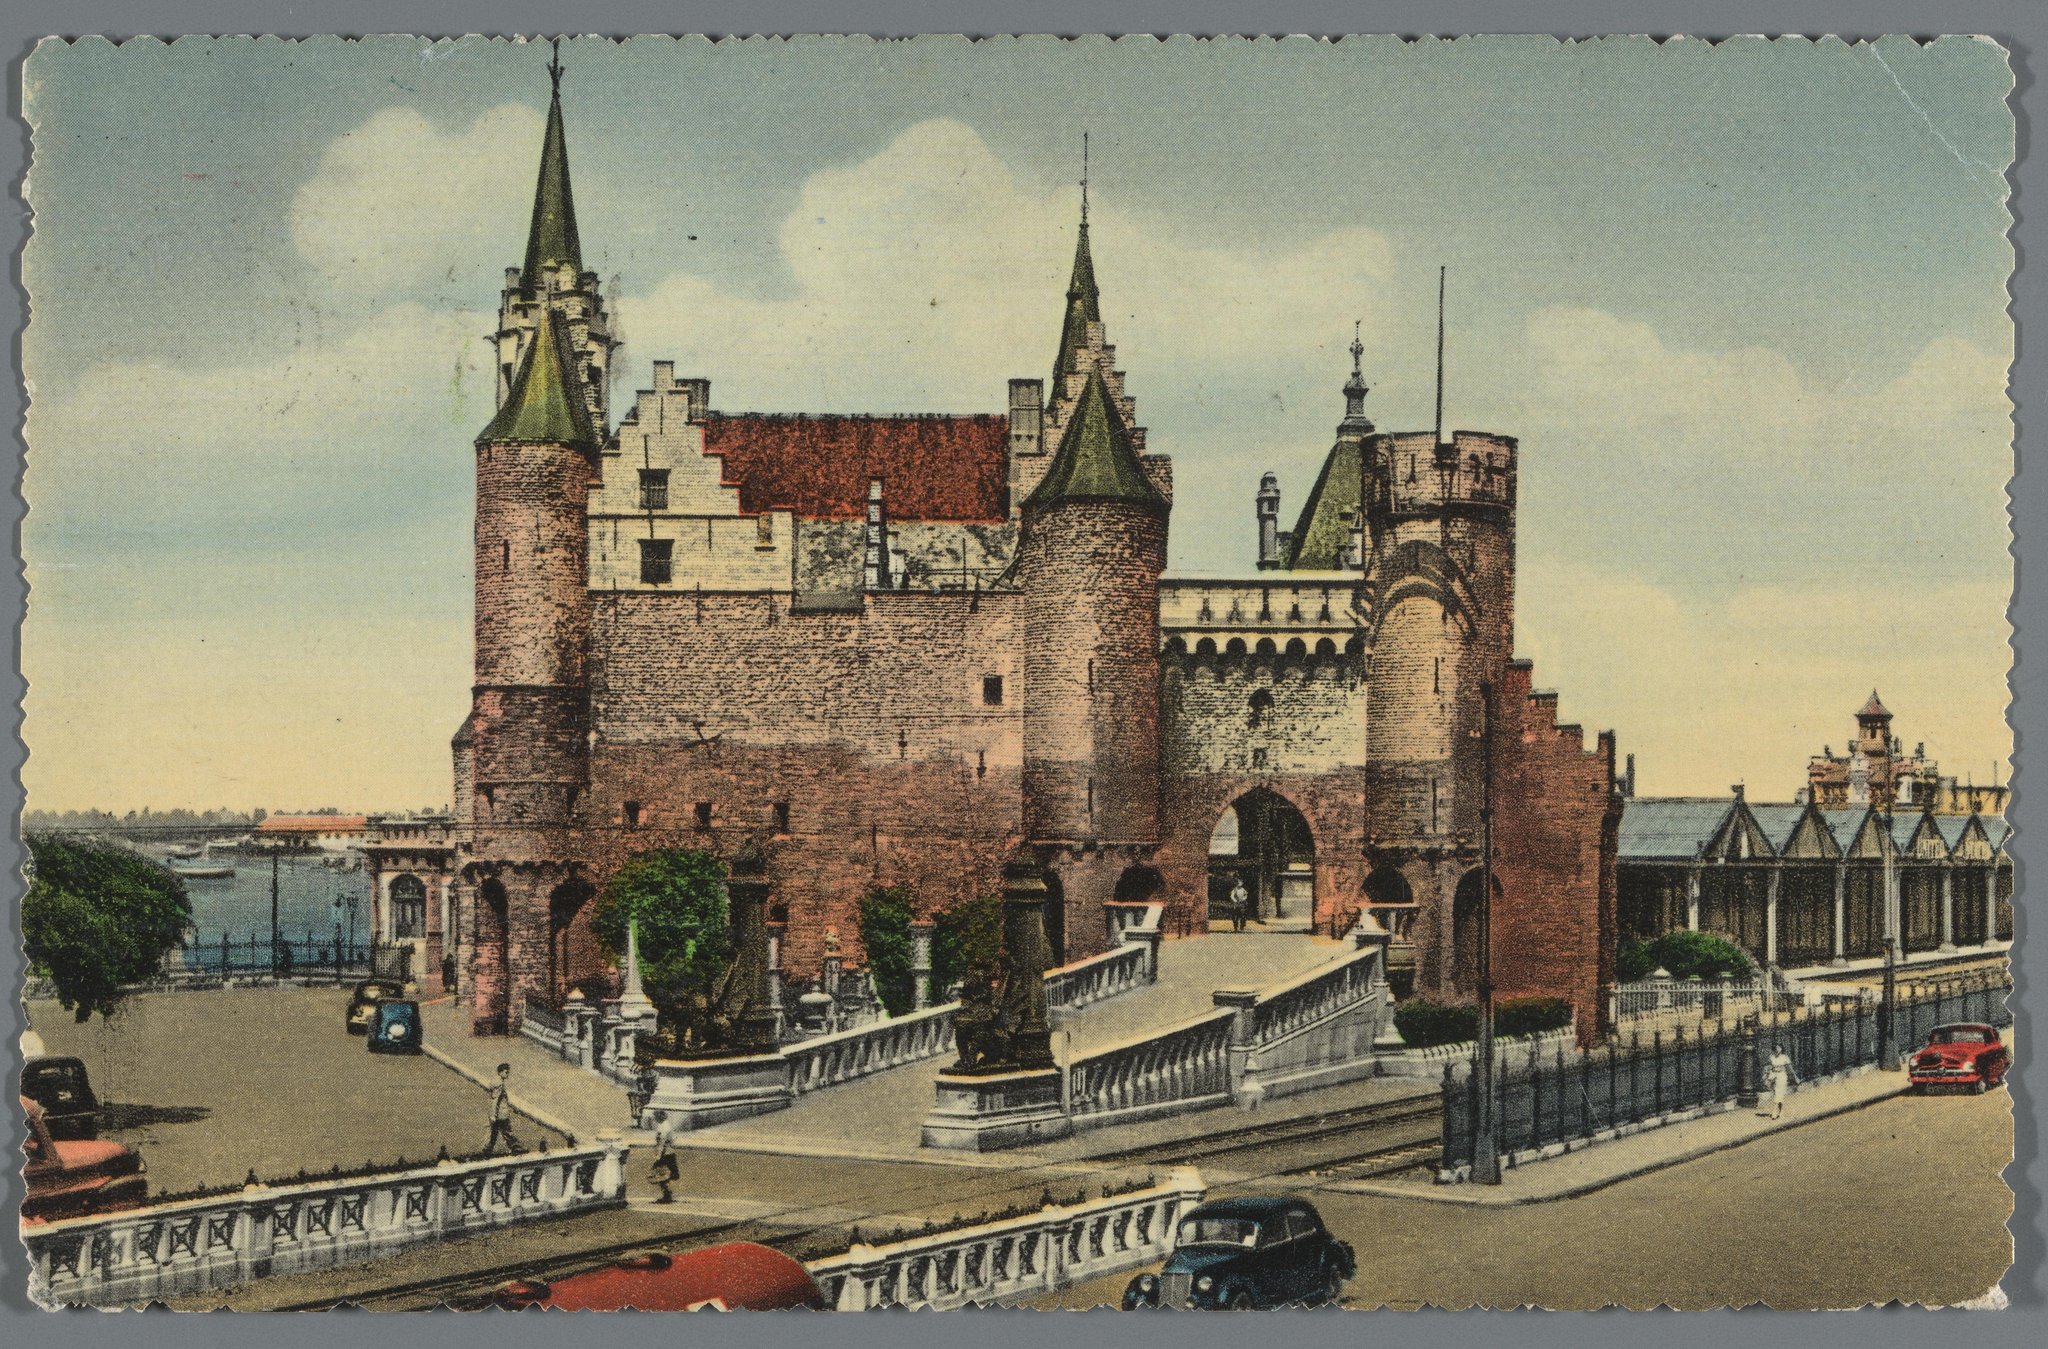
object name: postcard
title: Het Steen, Antwerpen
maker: Anonymous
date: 1900-1925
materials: photographic support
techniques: rotogravure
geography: antwerp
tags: het steen